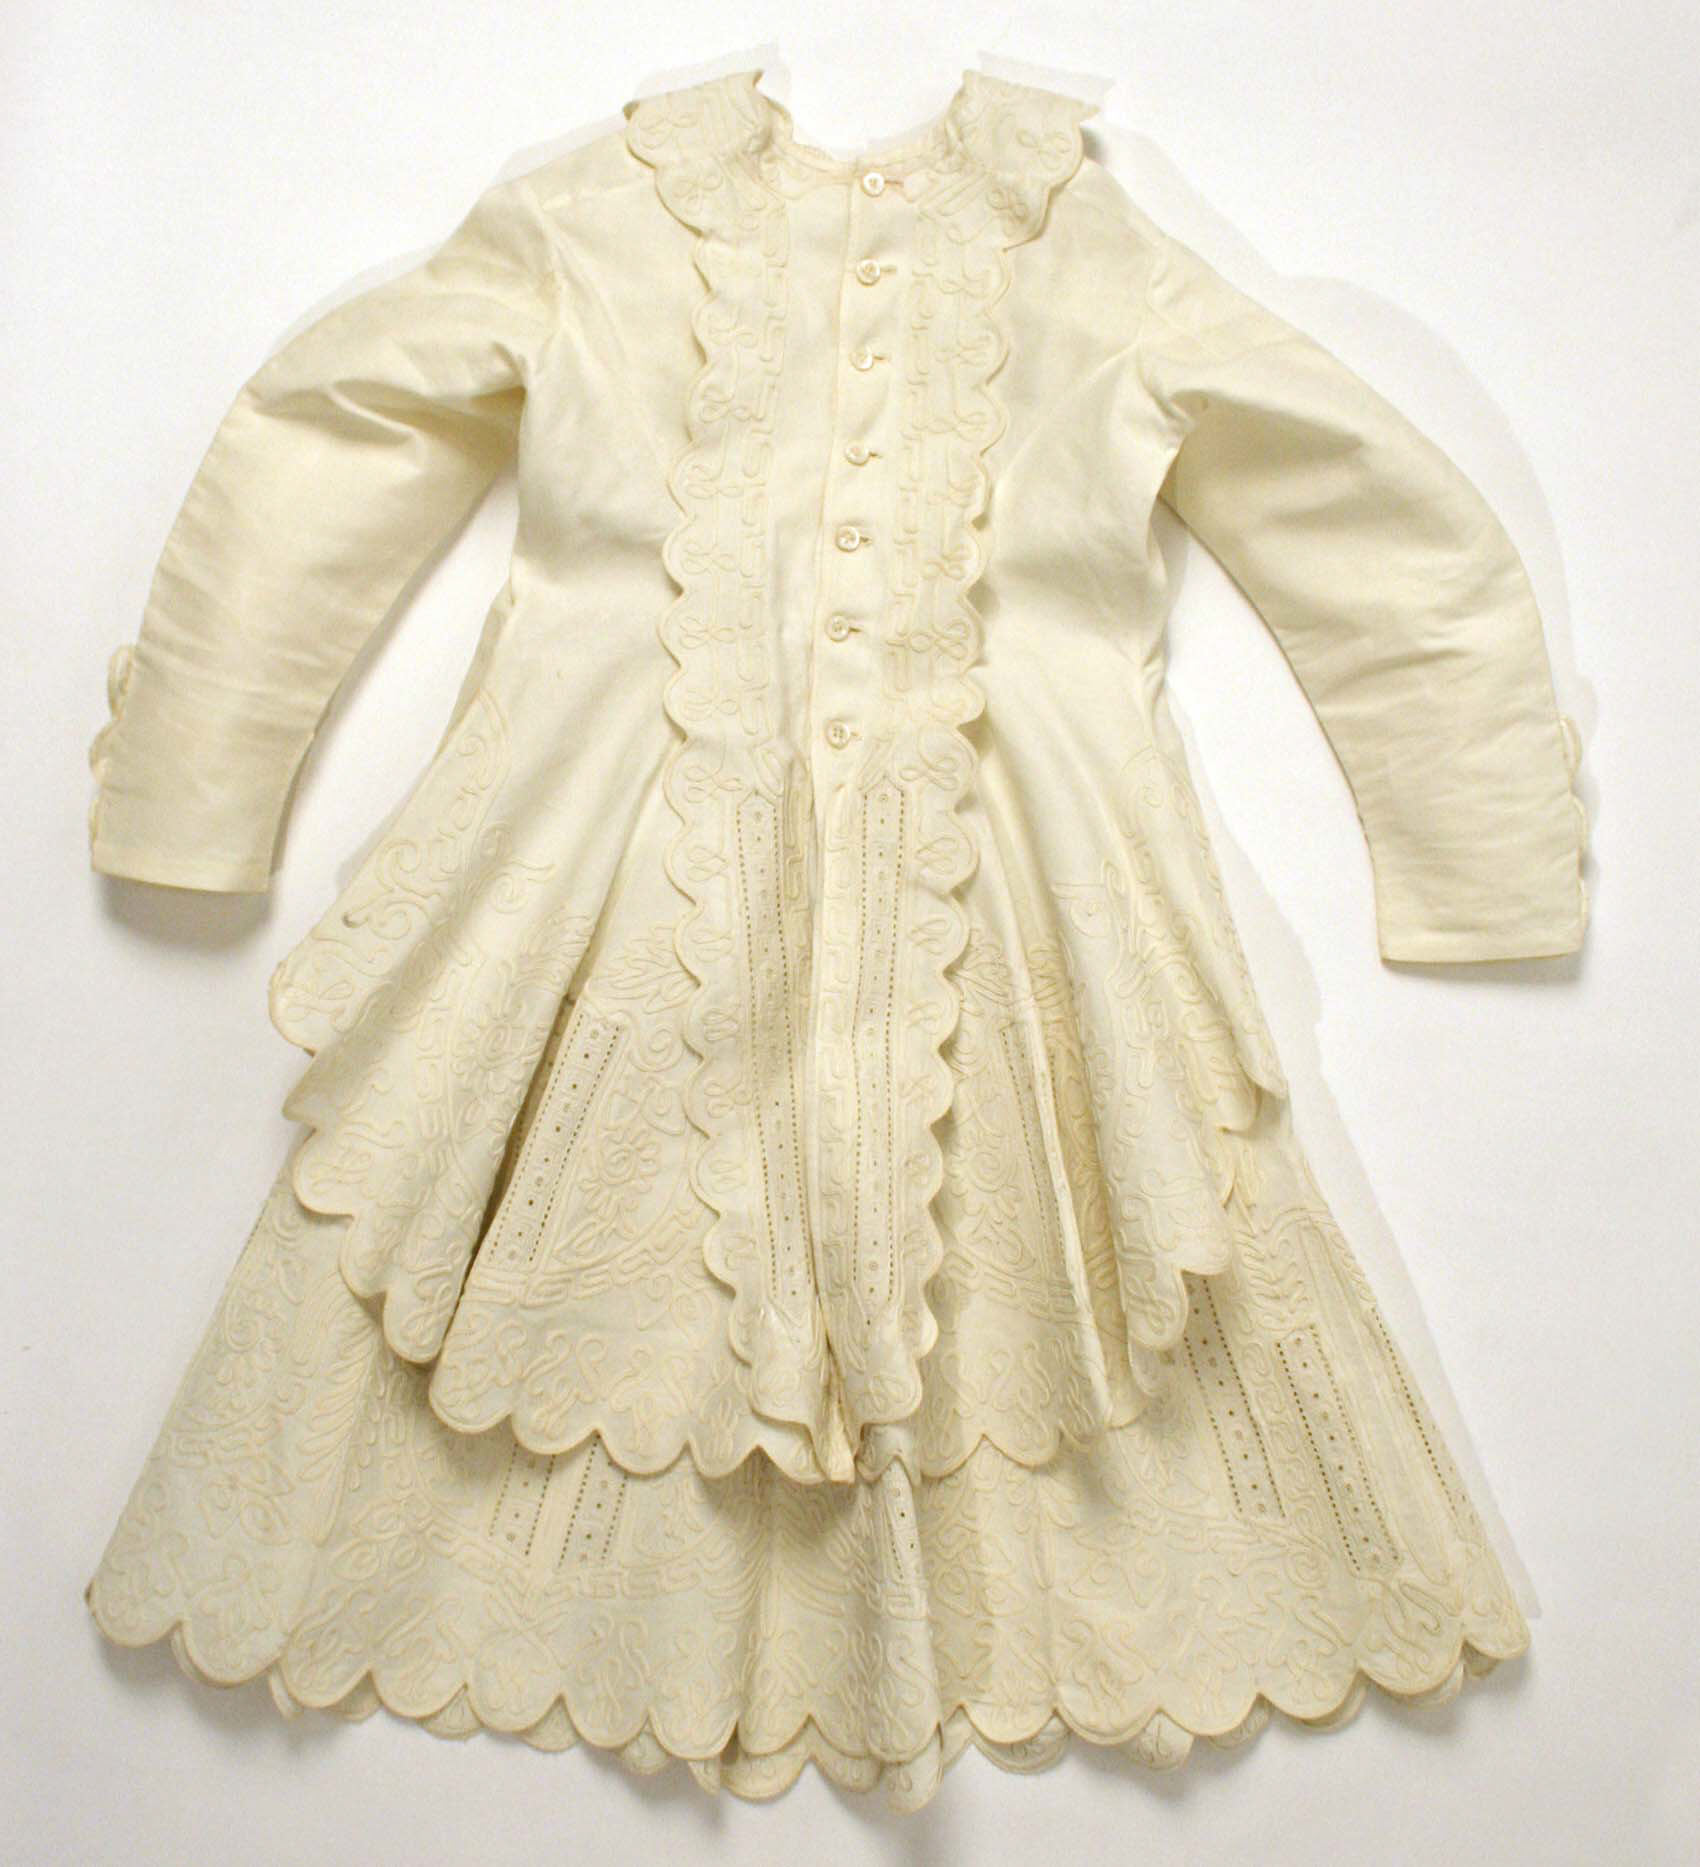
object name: dress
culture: american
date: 1867-1900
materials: cotton